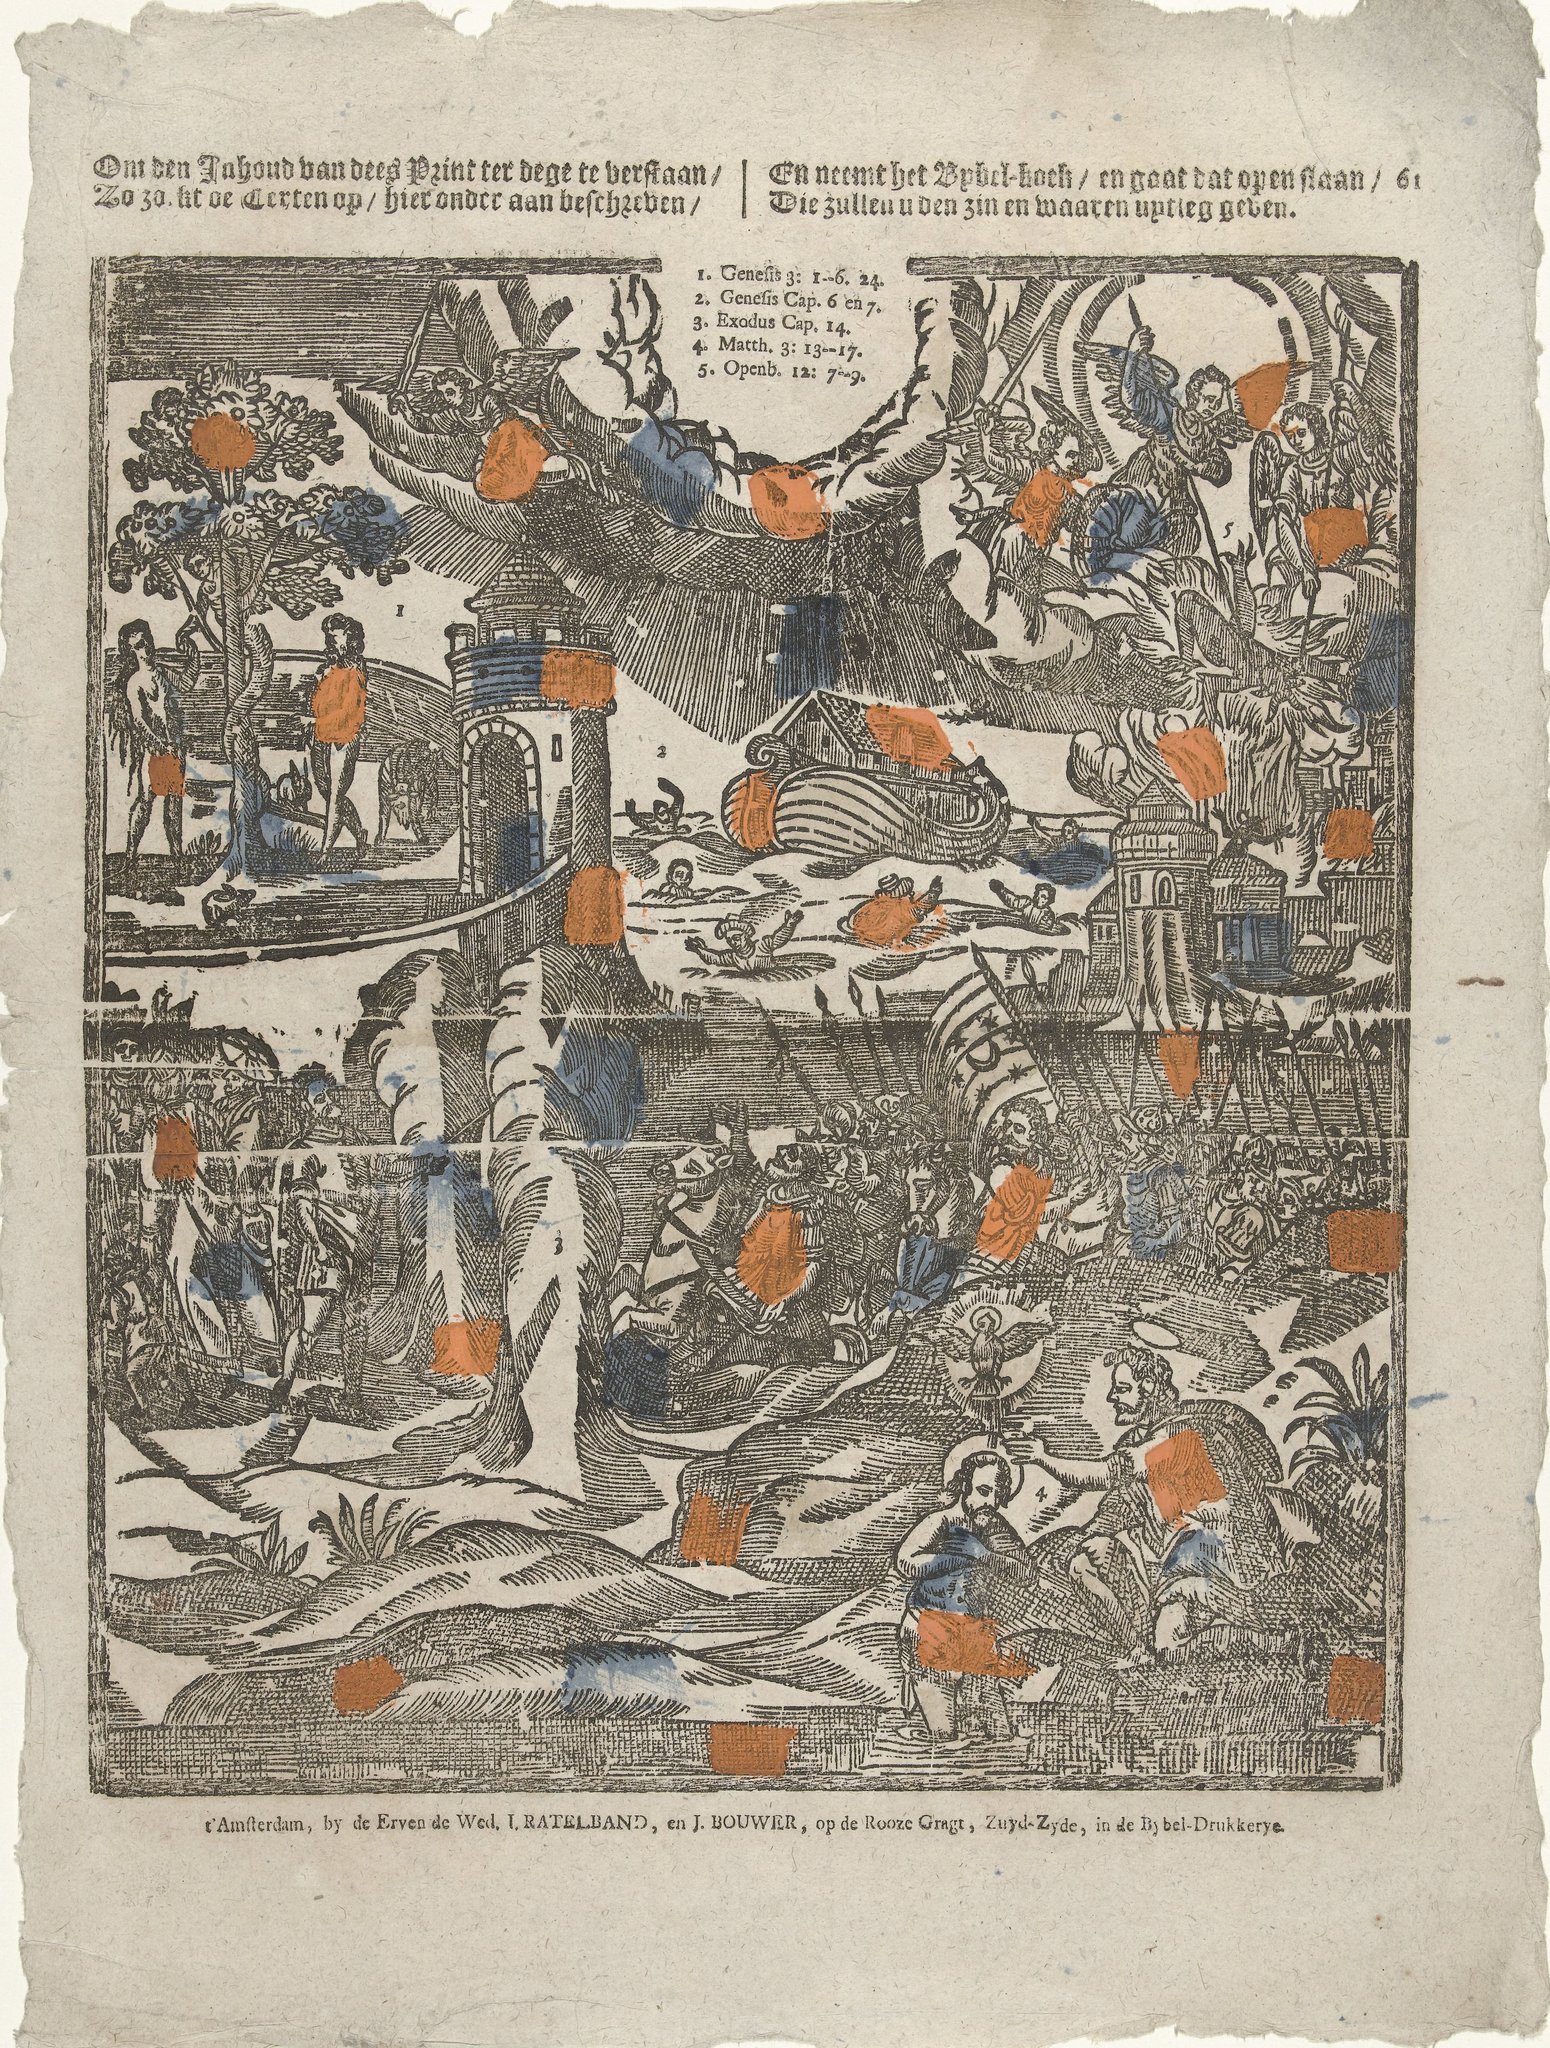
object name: print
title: Om den inhoud van dees print ter dege te verstaan / Zo zoekt de texten op / hier onder aan beschreven / En neemt het Bybel-boek / en gaat dat open slaan / Die zullen u den zin en waaren uytleg geven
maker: Anonymous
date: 1550-1650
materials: paper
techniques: colour, letterpress printing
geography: netherlands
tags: baptism of christ in the river jordan: john the baptist pouring out water on christ's head: the holy ghost descends, the fall of satan, fall of lucifer, the flood and destruction of mankind ~ story of noah (genesis 7:10 - 8:17), revelation 12-18, moses lifts up his rod and the water divides (red sea); the angel of god and the pillar of cloud move to the rear, temptation and fall: adam and eve in paradise (after the fall) (genesis 3:8-21)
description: Blok met vijf verhalen uit het Oude en het Nieuwe Testament in één voorstelling: de Zondeval, de Ark van Noach, de tocht door de Rode Zee, de doop van Christus en de val van Lucifer. Bovenaan de bijbelverwijzingen naar de vijf verhalen. Genummerd rechtsboven: 61.